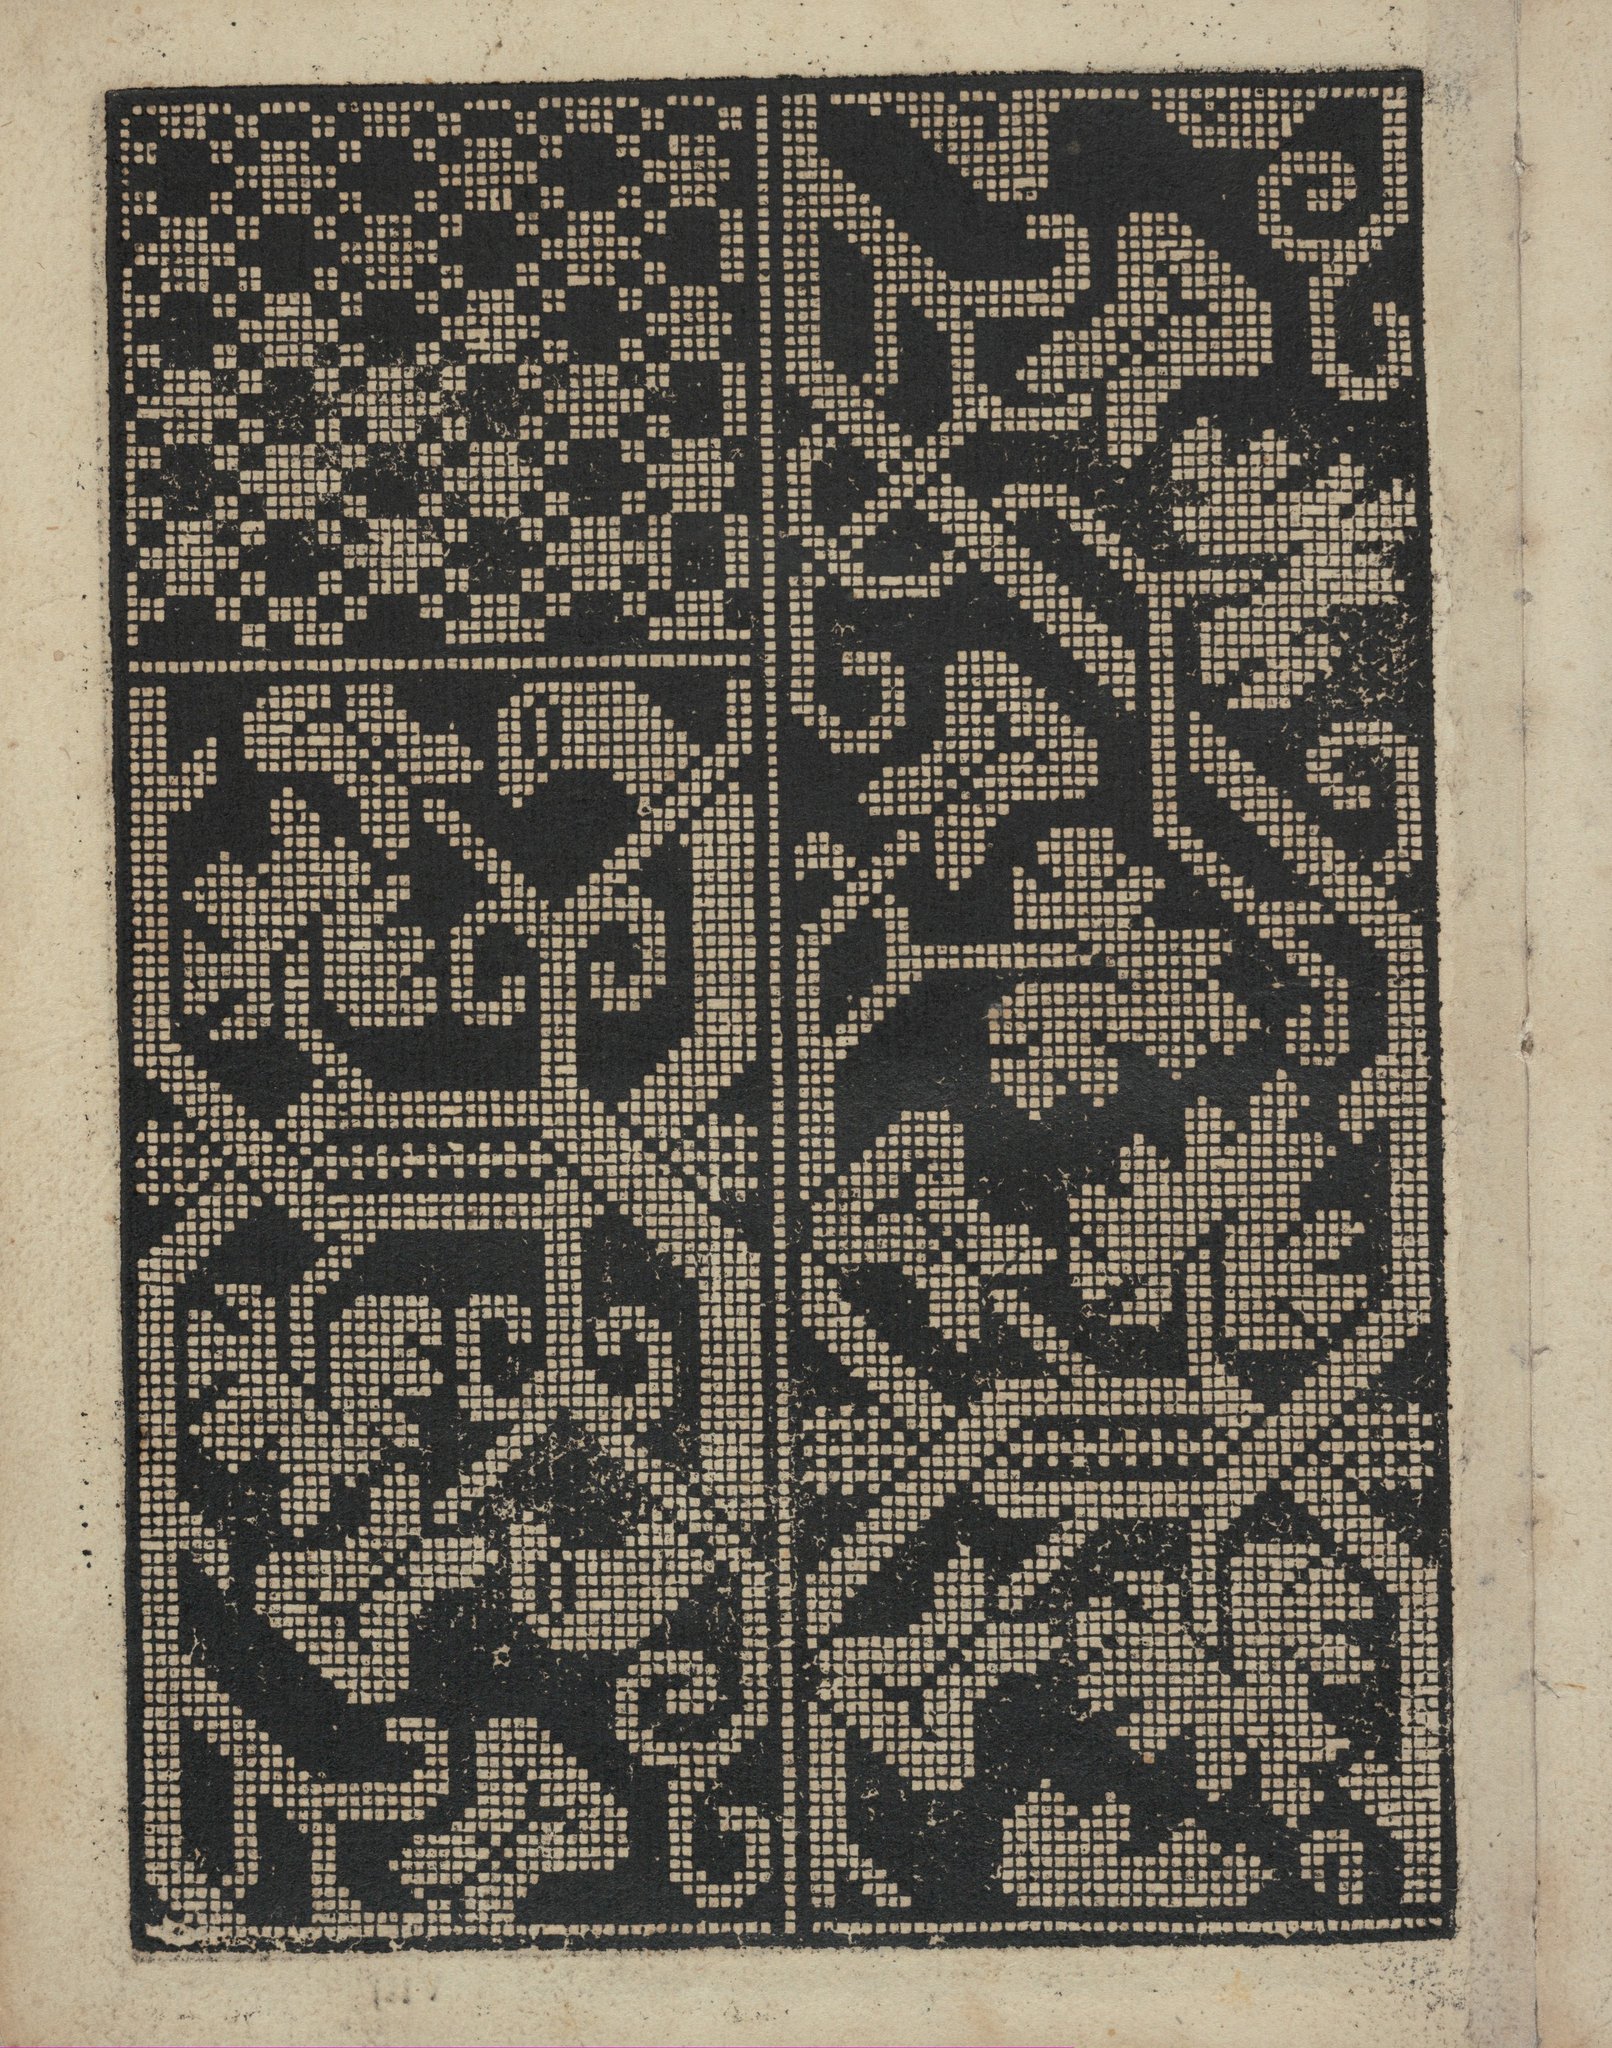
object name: book print ornament architecture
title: Libbretto nouellamete composto per maestro Domenico da Sera...lauorare di ogni sorte di punti, page 8 (verso)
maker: domenico da sera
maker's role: publisher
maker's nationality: french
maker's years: 1500-1599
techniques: woodcut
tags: ornament